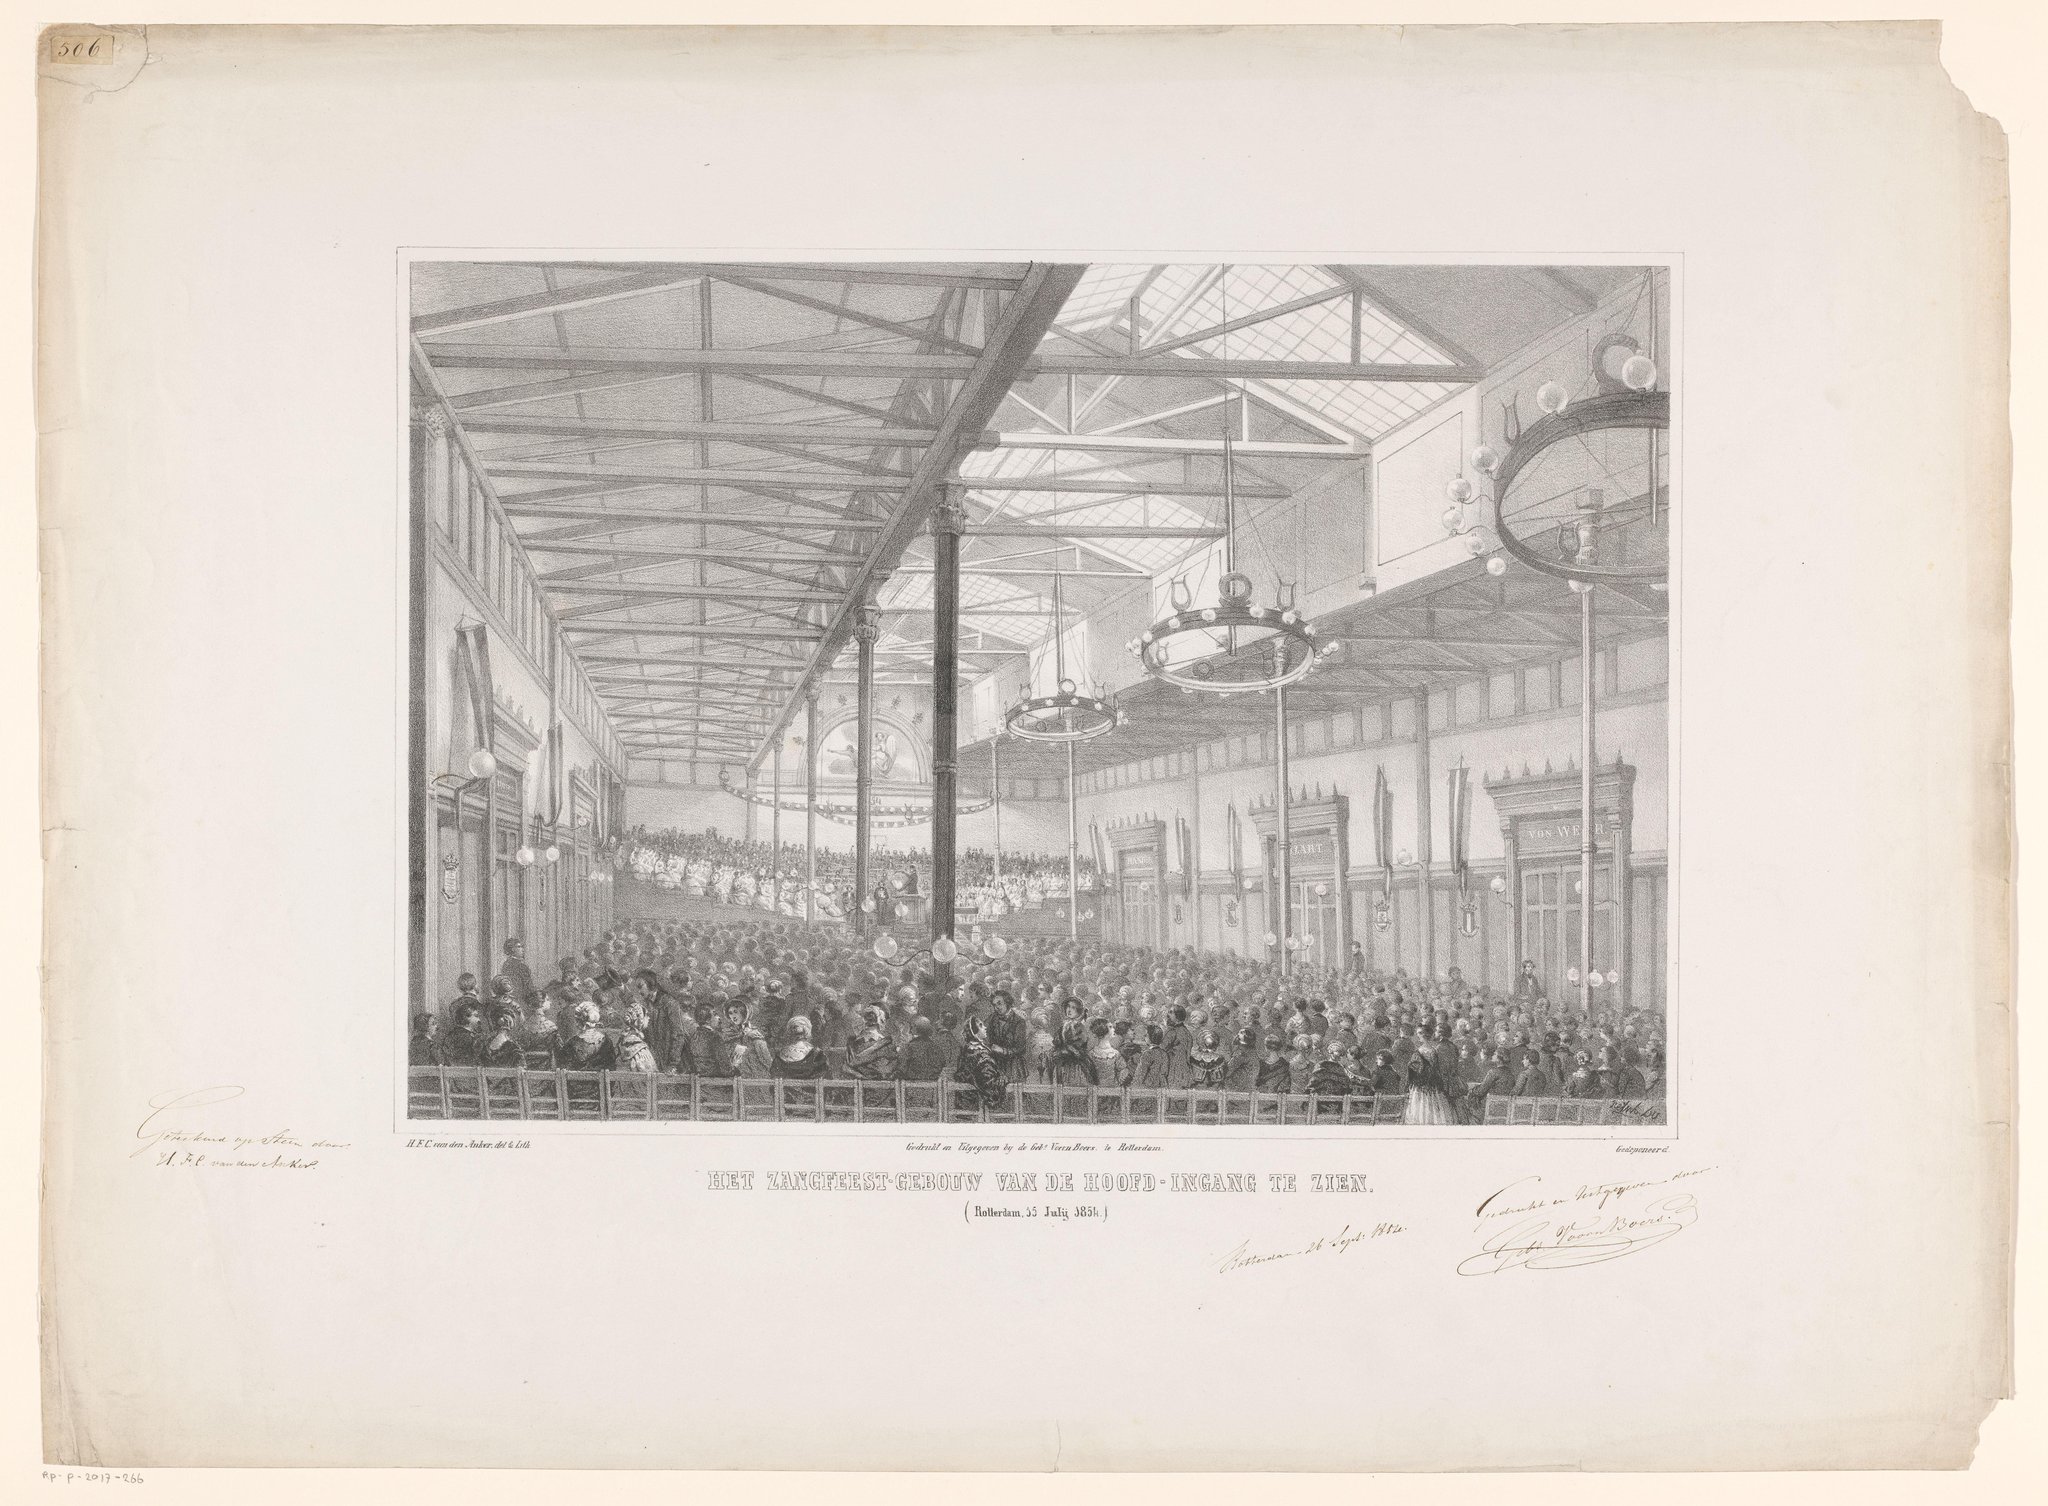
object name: print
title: Concert in het concertgebouw van het muziekfestival in Rotterdam in 1854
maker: hermanus franciscus carolus van den anker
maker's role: print maker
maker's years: 1832-1883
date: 1854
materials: paper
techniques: lithograph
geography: rotterdam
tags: the hague, johannes verhulst, conductor ~ music, concert hall, rotterdam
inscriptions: : ‘Geteekend op steen door / H.F.C. van den Anker’, : ‘Rotterdam 26 sept. 1854 Gedrukt en uitgegeven door / Gebr. VoornBoers’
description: Een volle zaal luistert naar de Negende Symfonie van Beethoven uitgevoerd op 15 juli 1854. Op de bok staat Johannes Verhulst.